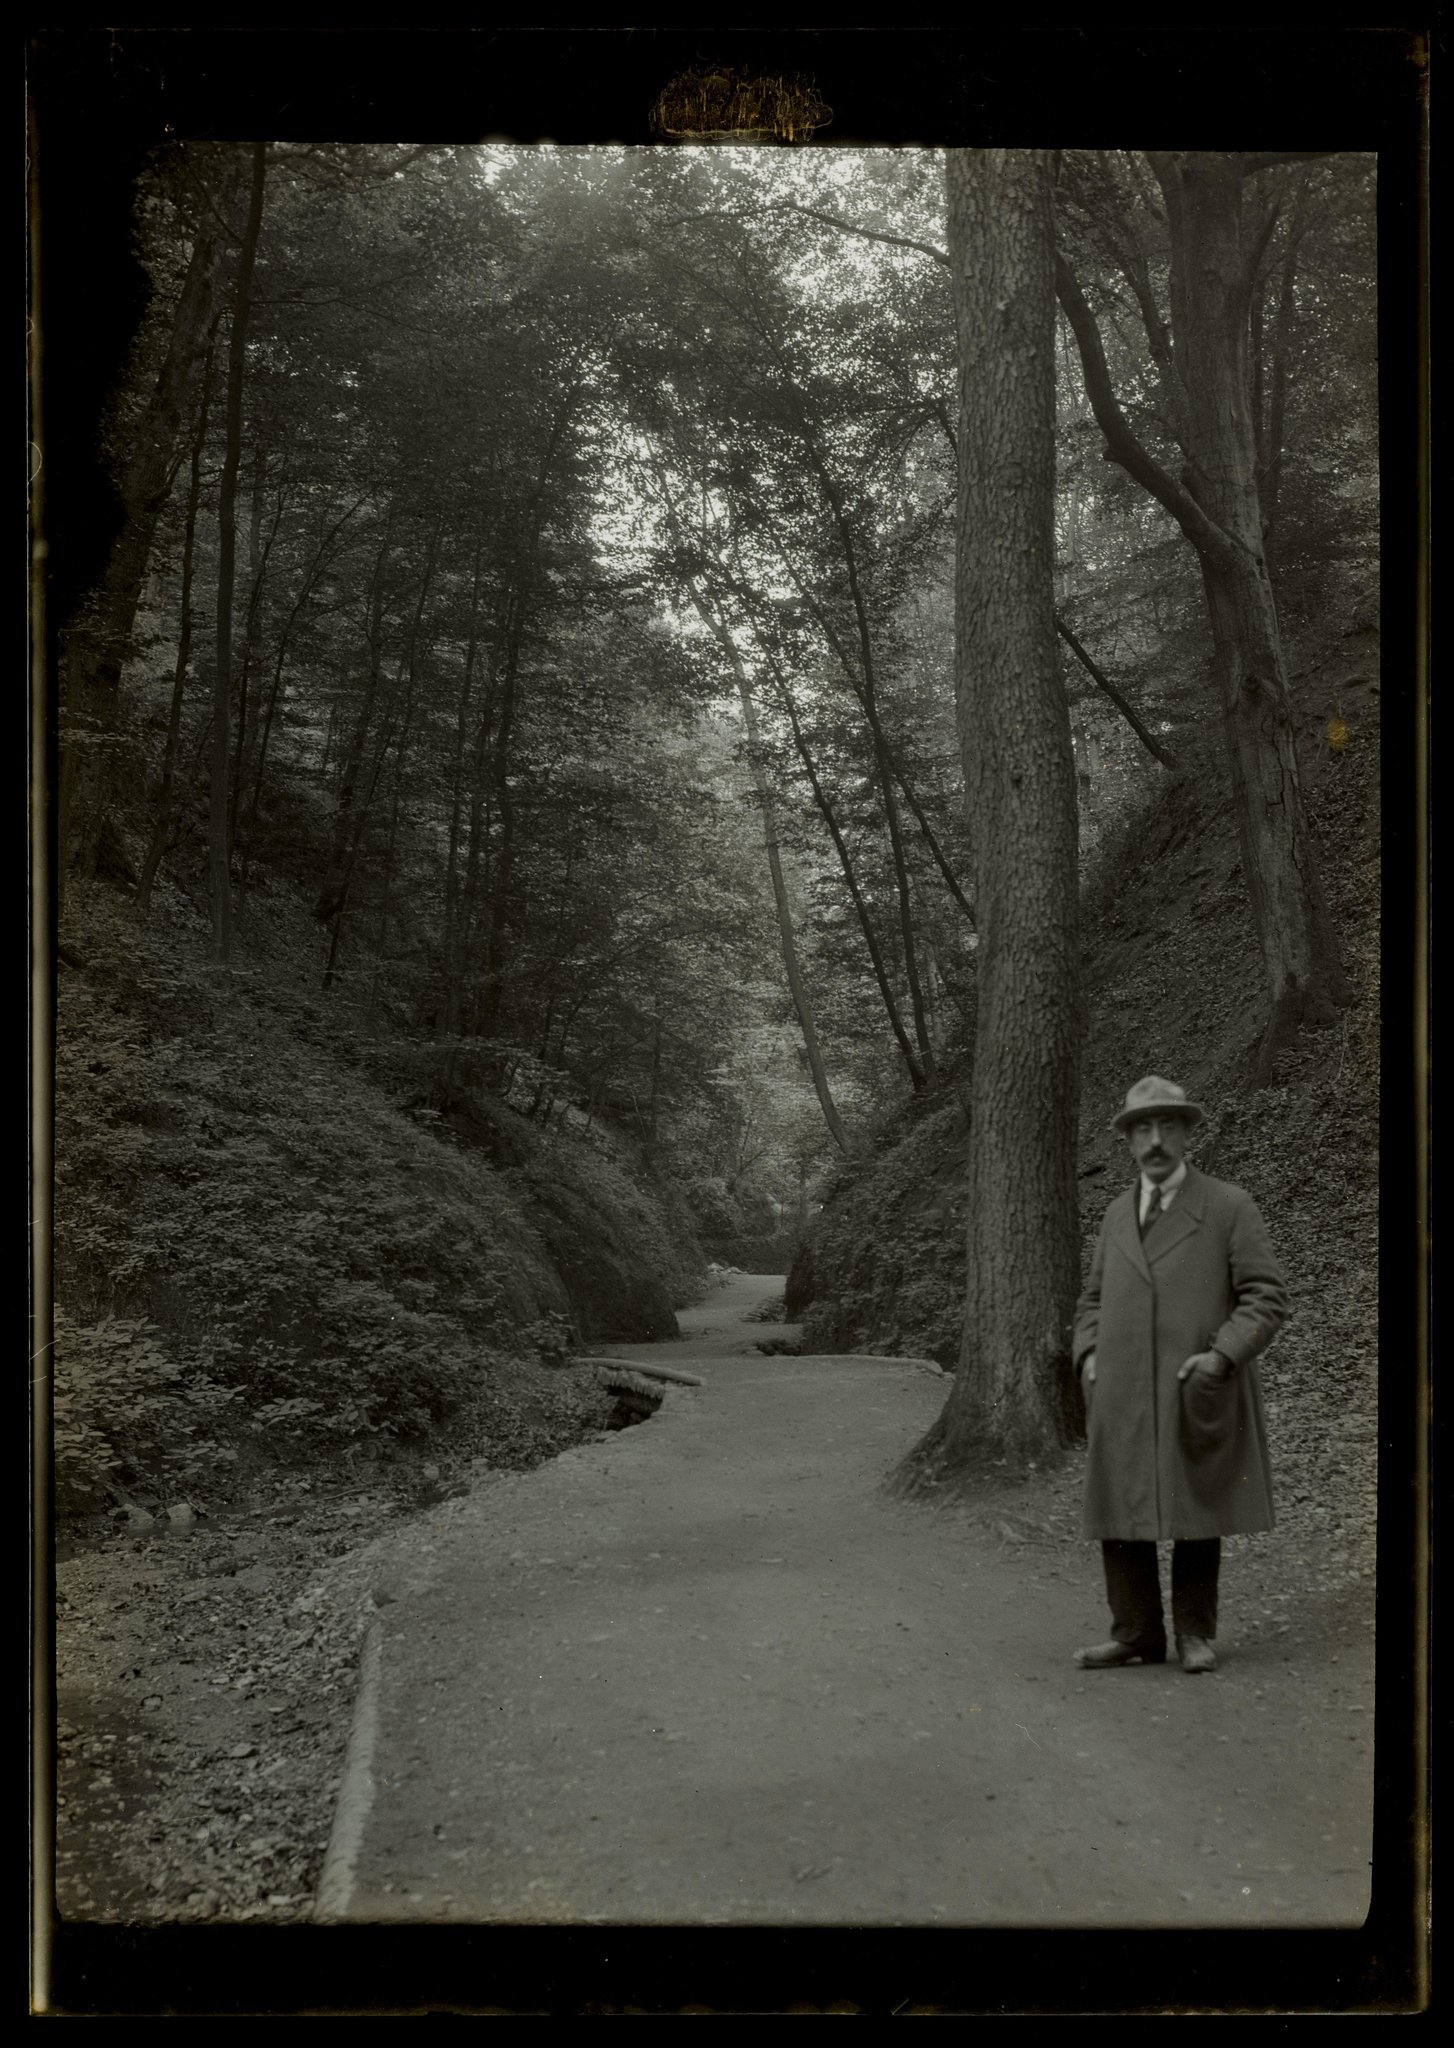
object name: negative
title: Negatief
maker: Anonymous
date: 1907-1935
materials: film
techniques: gelatin silver negative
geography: netherlands